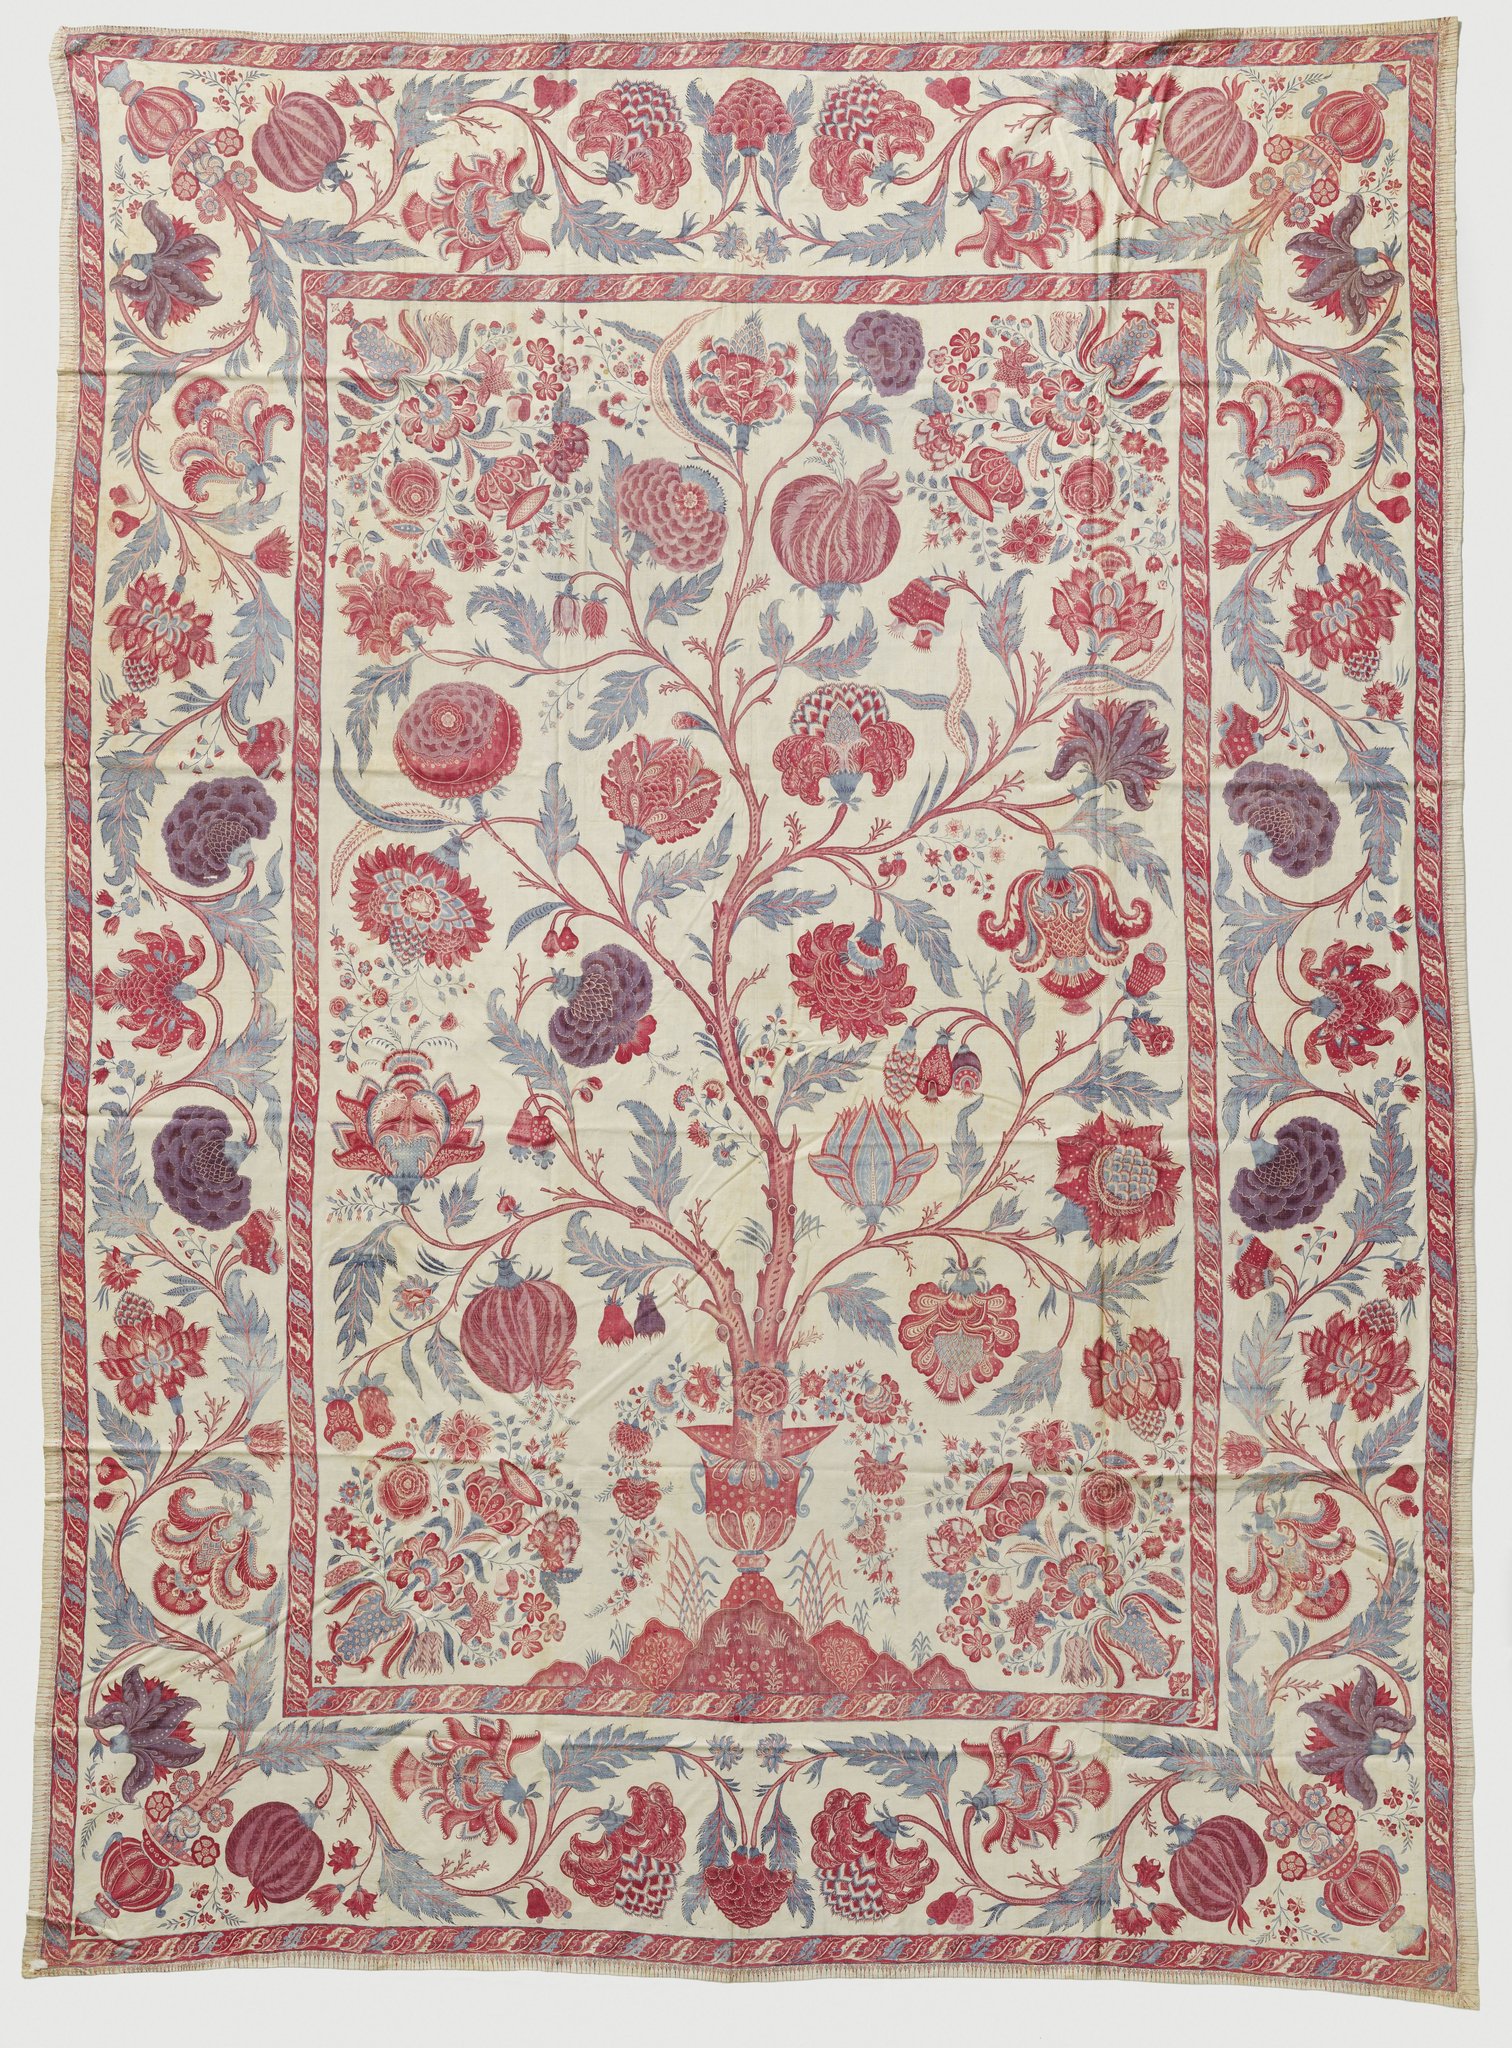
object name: bedspread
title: Chintz palampore with floweringtree motif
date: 1725-1750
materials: cotton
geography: coromandel coast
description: Palempore van sits met patroon van bloeiende boom.